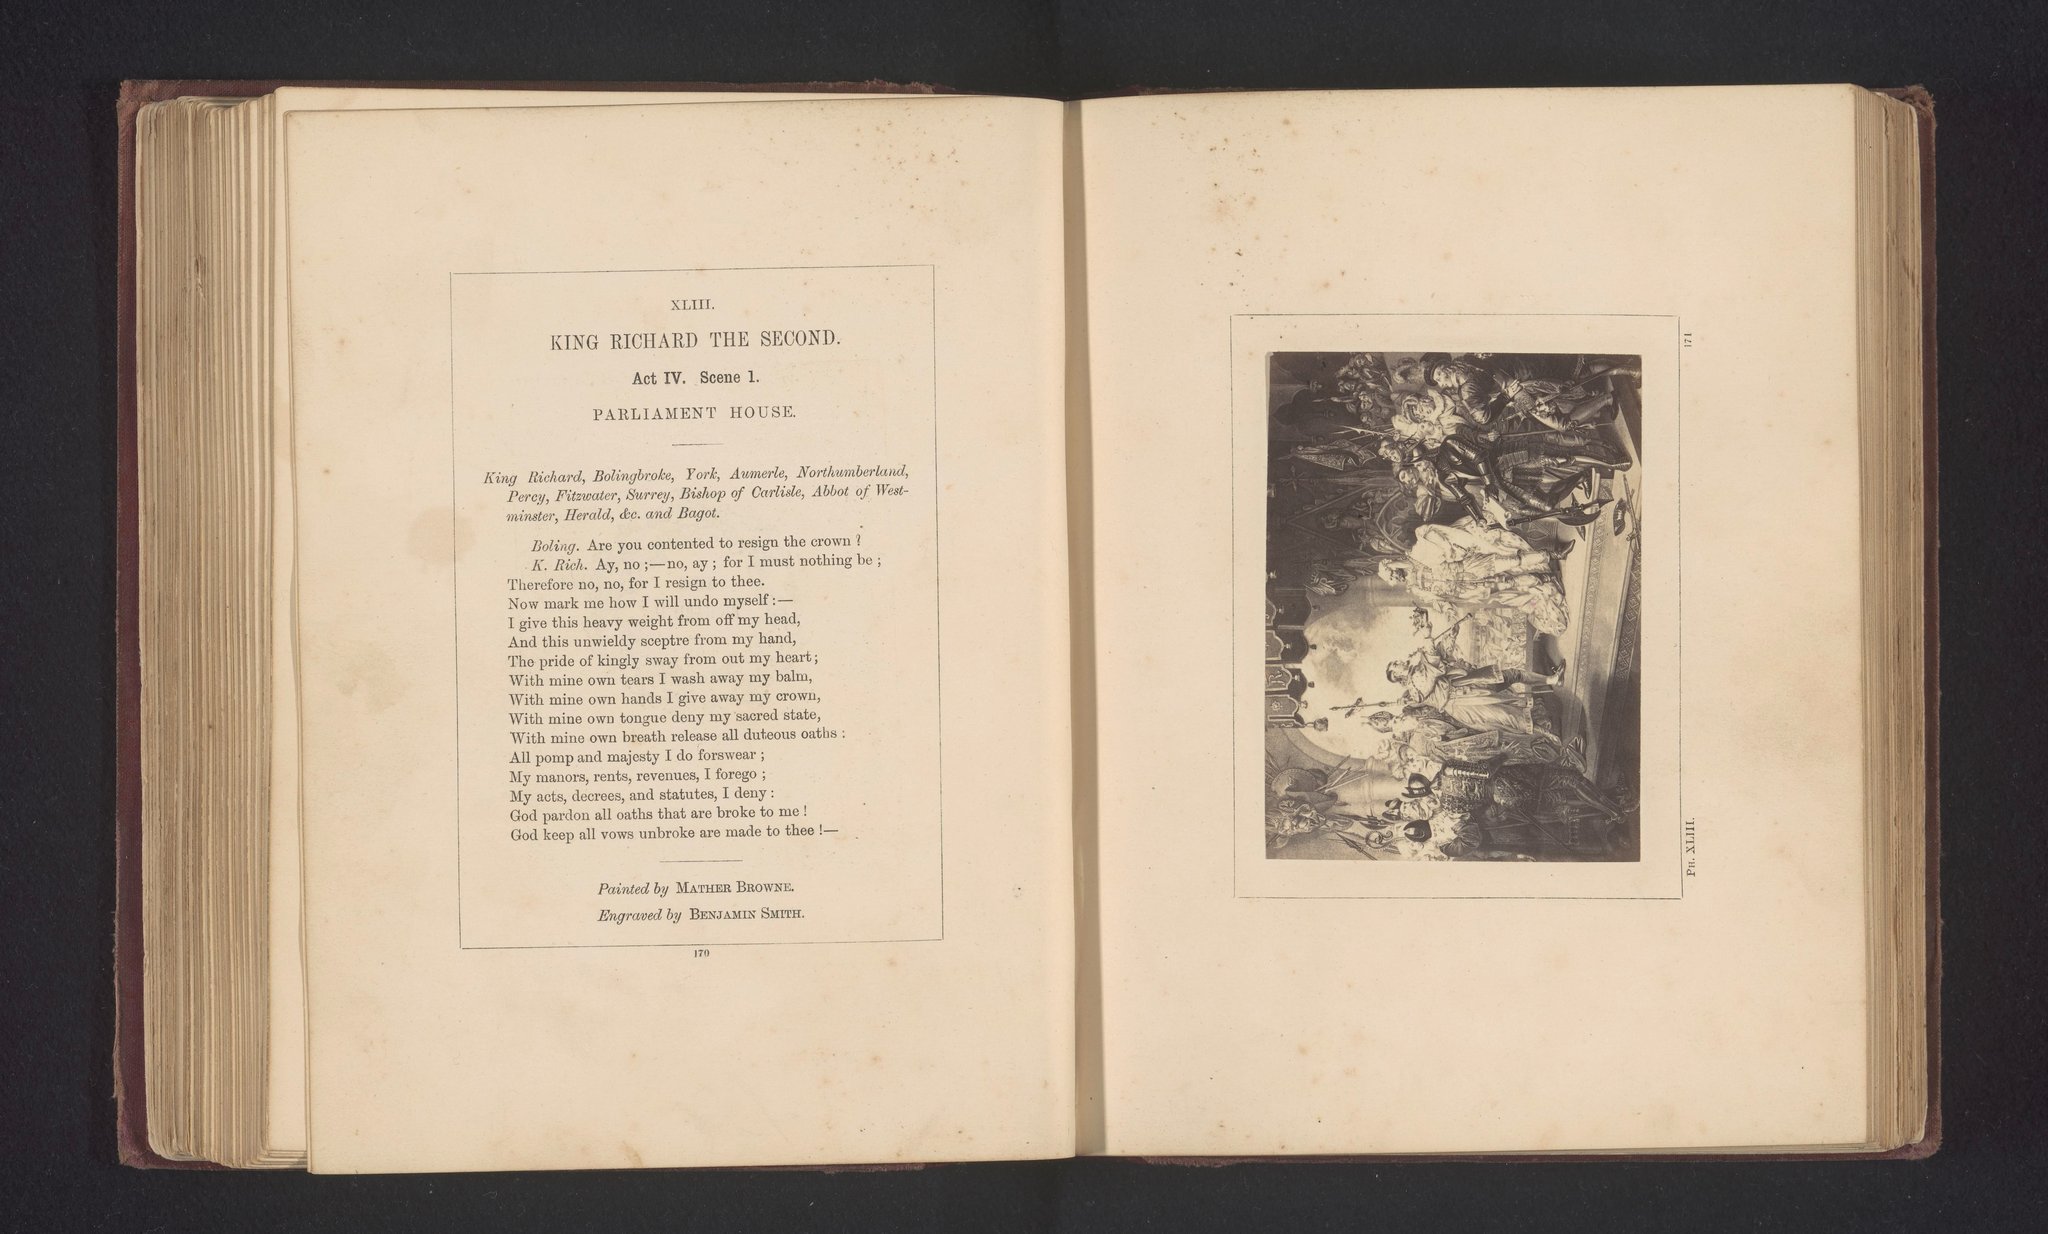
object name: reproduction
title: Fotoreproductie van een prent naar een schilderij door Mather Brown, voorstellend een scene uit Richard II door William Shakespeare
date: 1854-1867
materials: photographic support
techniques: albumen print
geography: london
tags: specific works of literature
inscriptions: number: ‘Ph. XLIII. 171’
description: Te zien is akte IV, scene 1 in een parlementsgebouw.